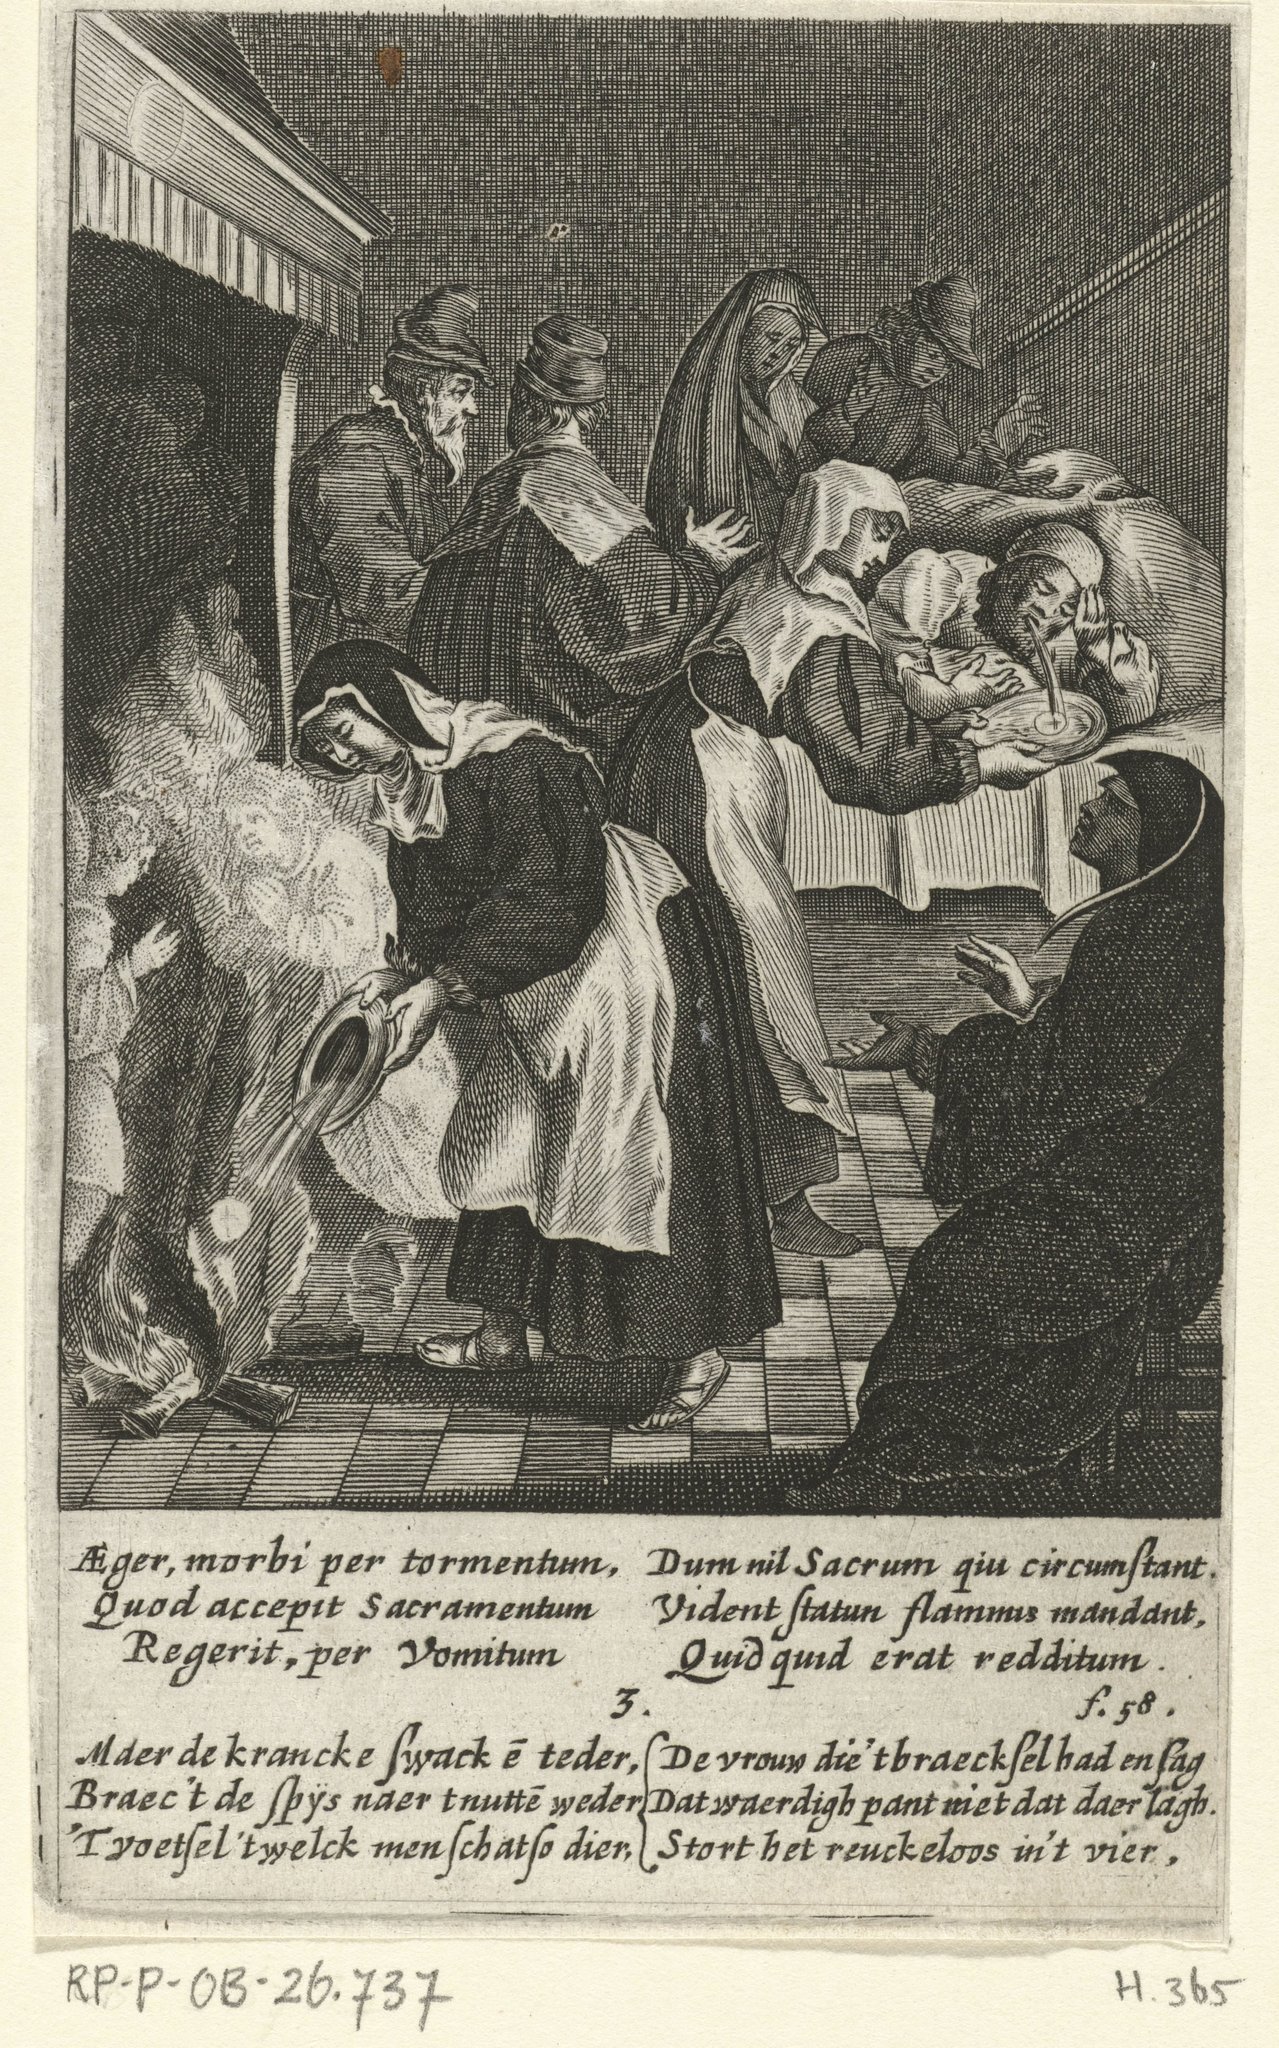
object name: print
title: Mirakel van Amsterdam 1345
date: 1590-1633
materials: paper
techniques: engraving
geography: antwerp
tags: legends and miracles associated with the eucharist (or the host), patient, sick person, nursing, tending the sick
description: Prent uit: Leonardus Marius, Amstelredams eer ende opcomen, door de denckwaerdighe miraklen aldaer geschied aen ende door het H. Sacrament des Altaers Anno 1345, Antwerpen, Hendrick Aertssens, 1639, afb. 3